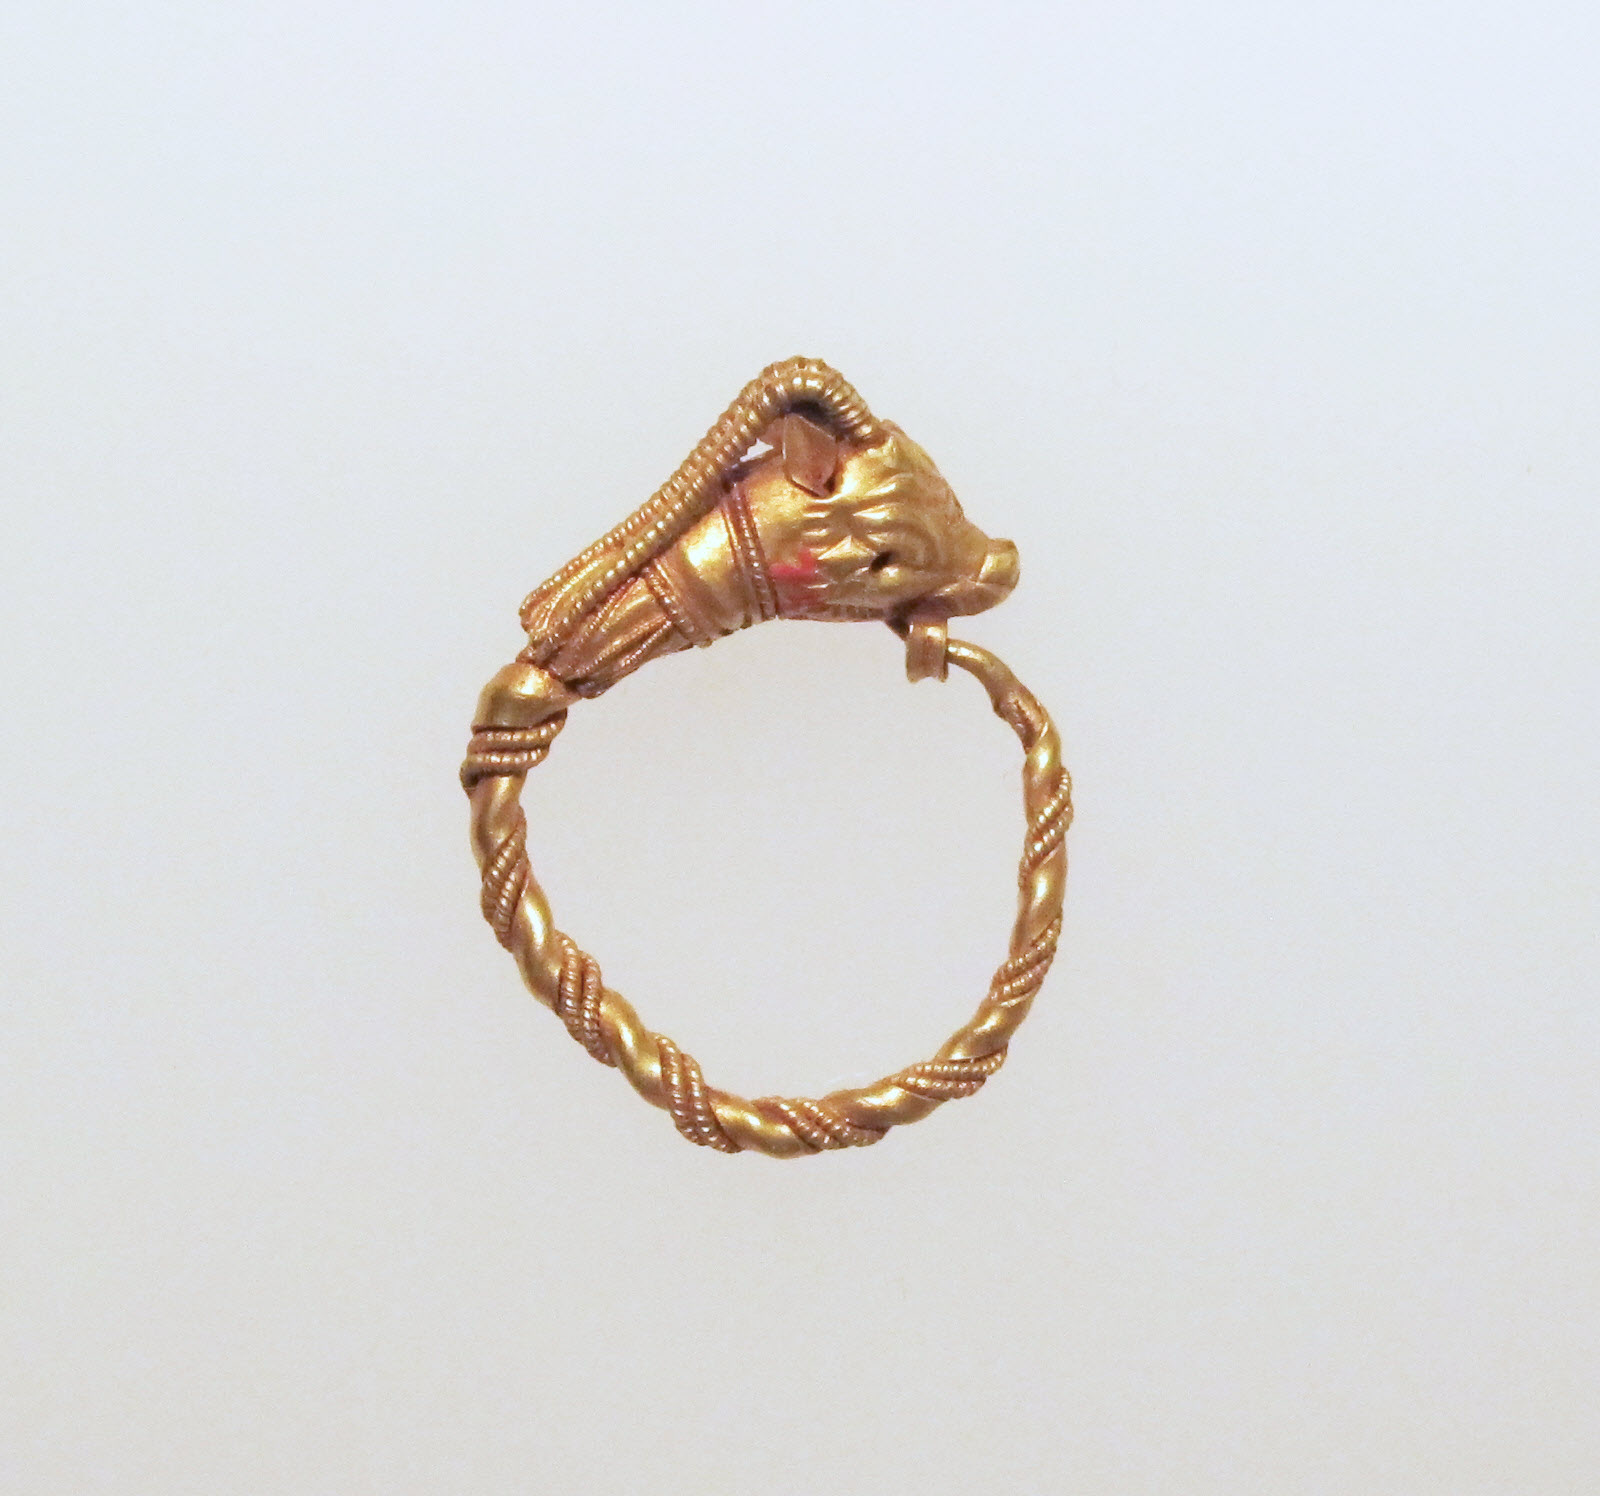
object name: earring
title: Gold earring with head of an antelope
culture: greek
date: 400-201 BCE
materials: gold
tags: animals